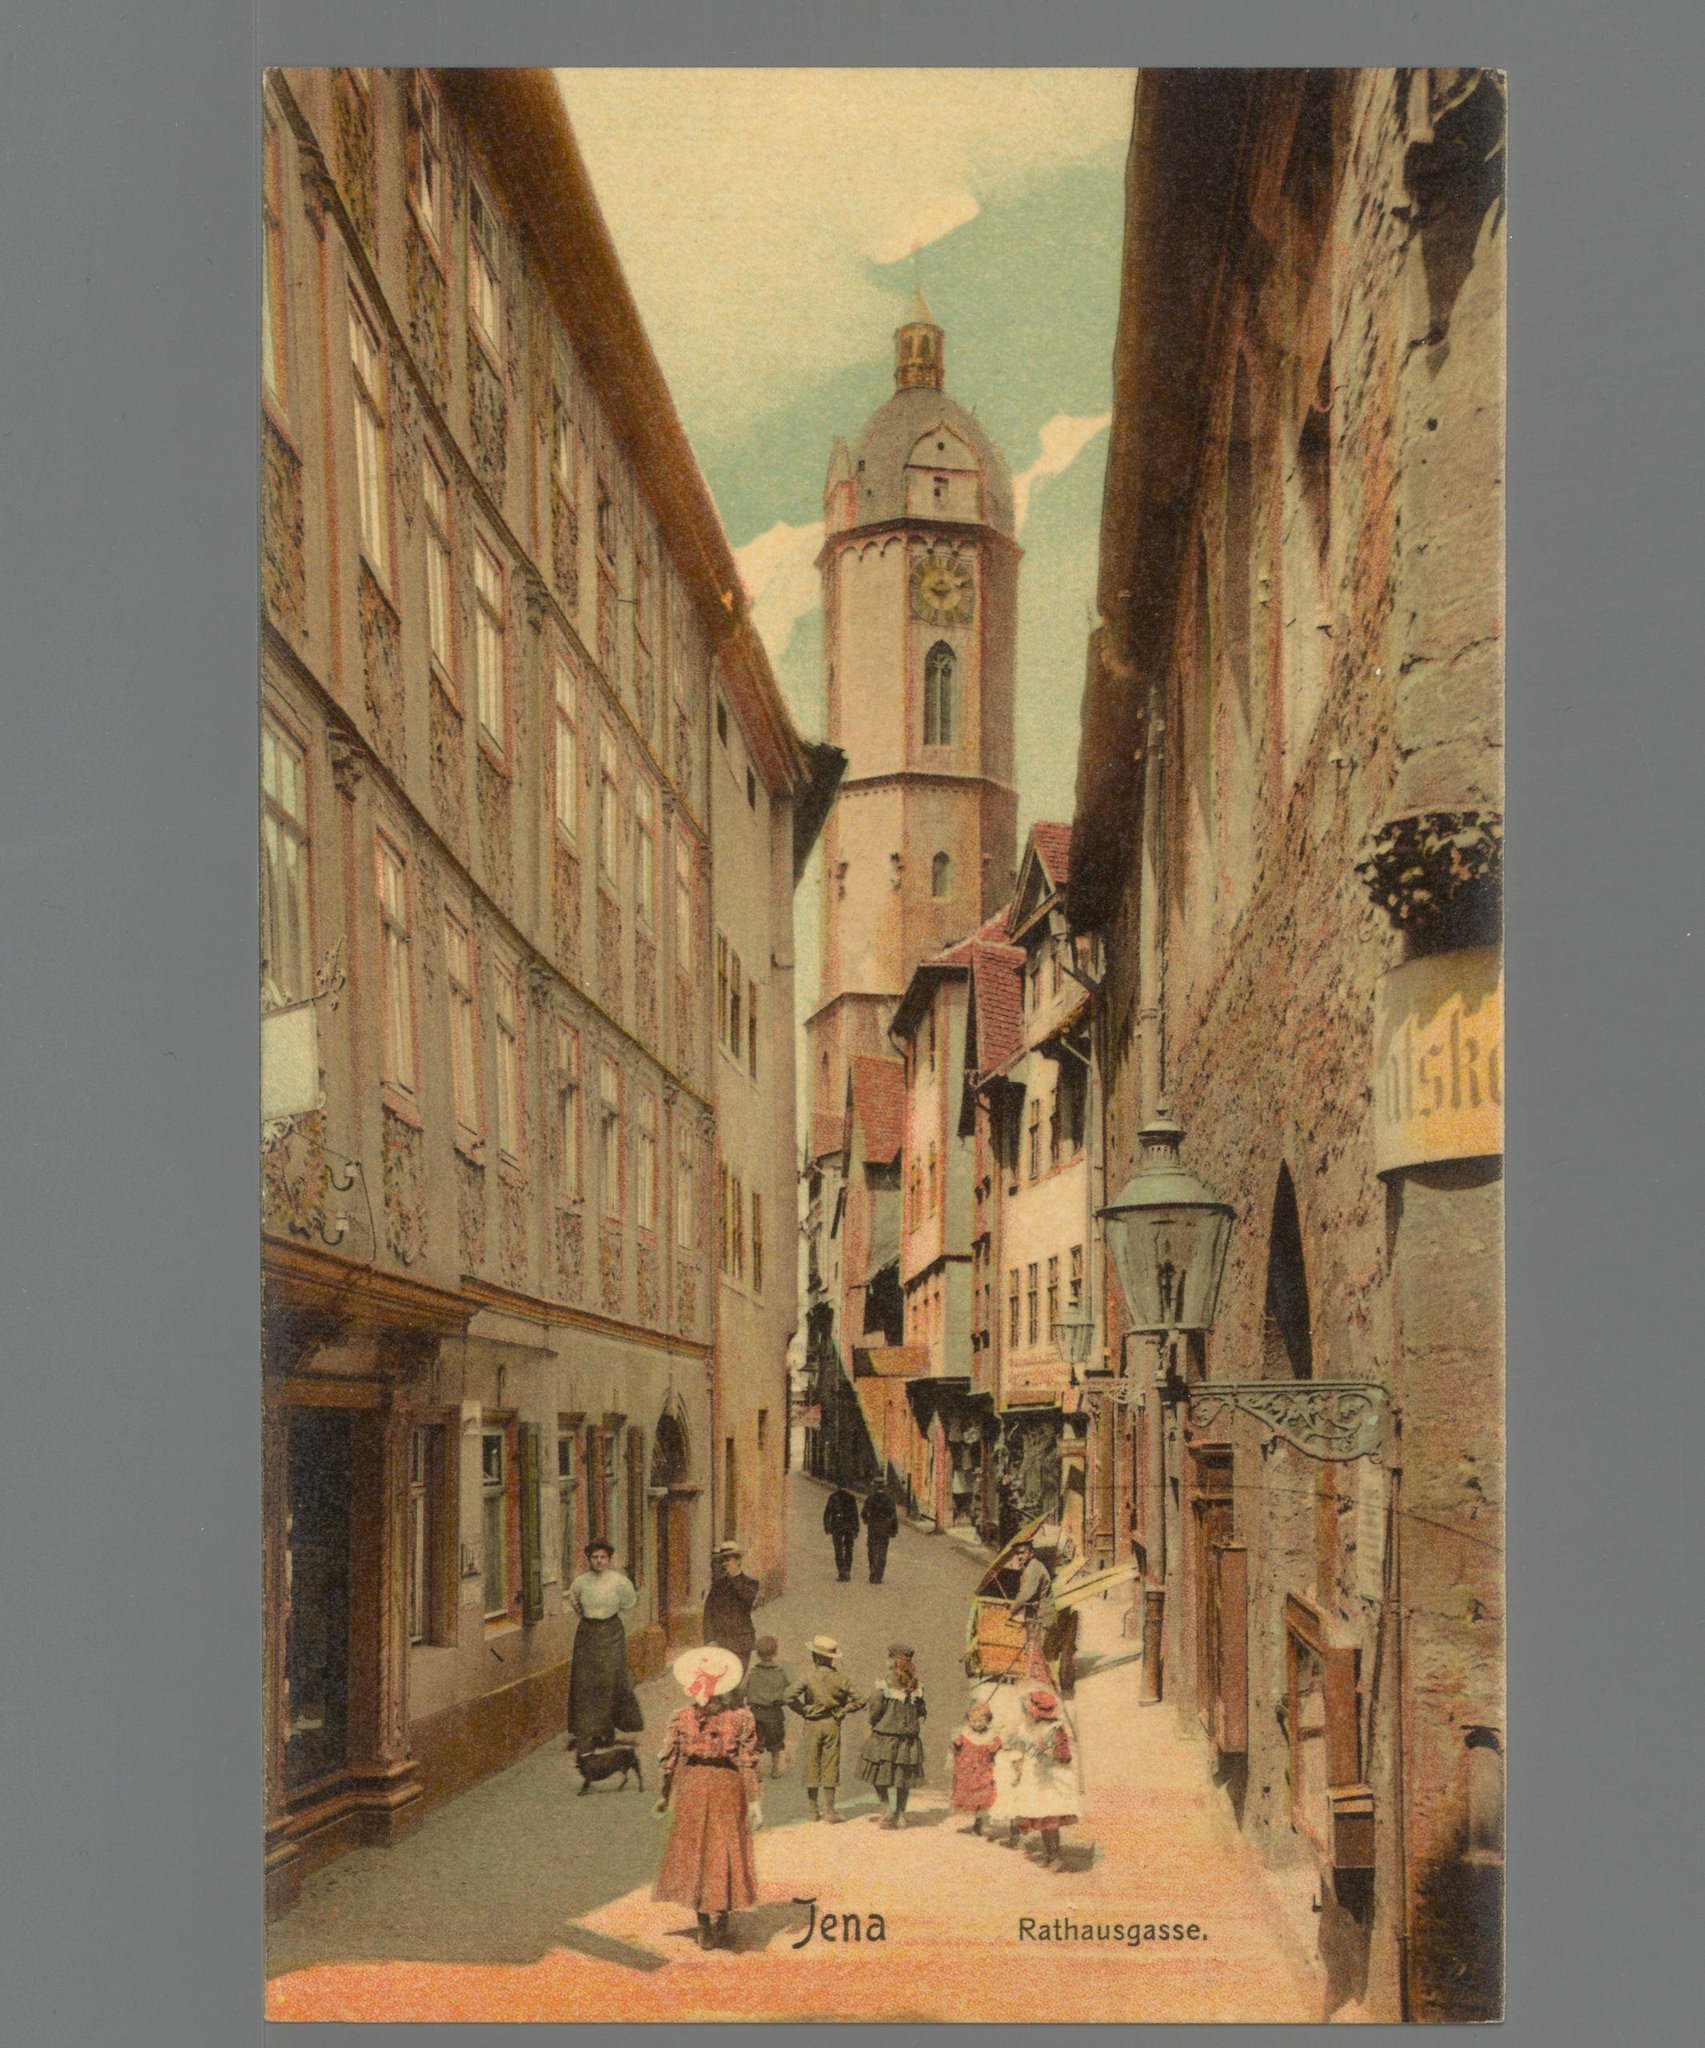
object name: photomechanical print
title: Jena. Rathausgasse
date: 1905-1930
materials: cardboard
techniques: photograph, lithograph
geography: jena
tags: church (exterior), street